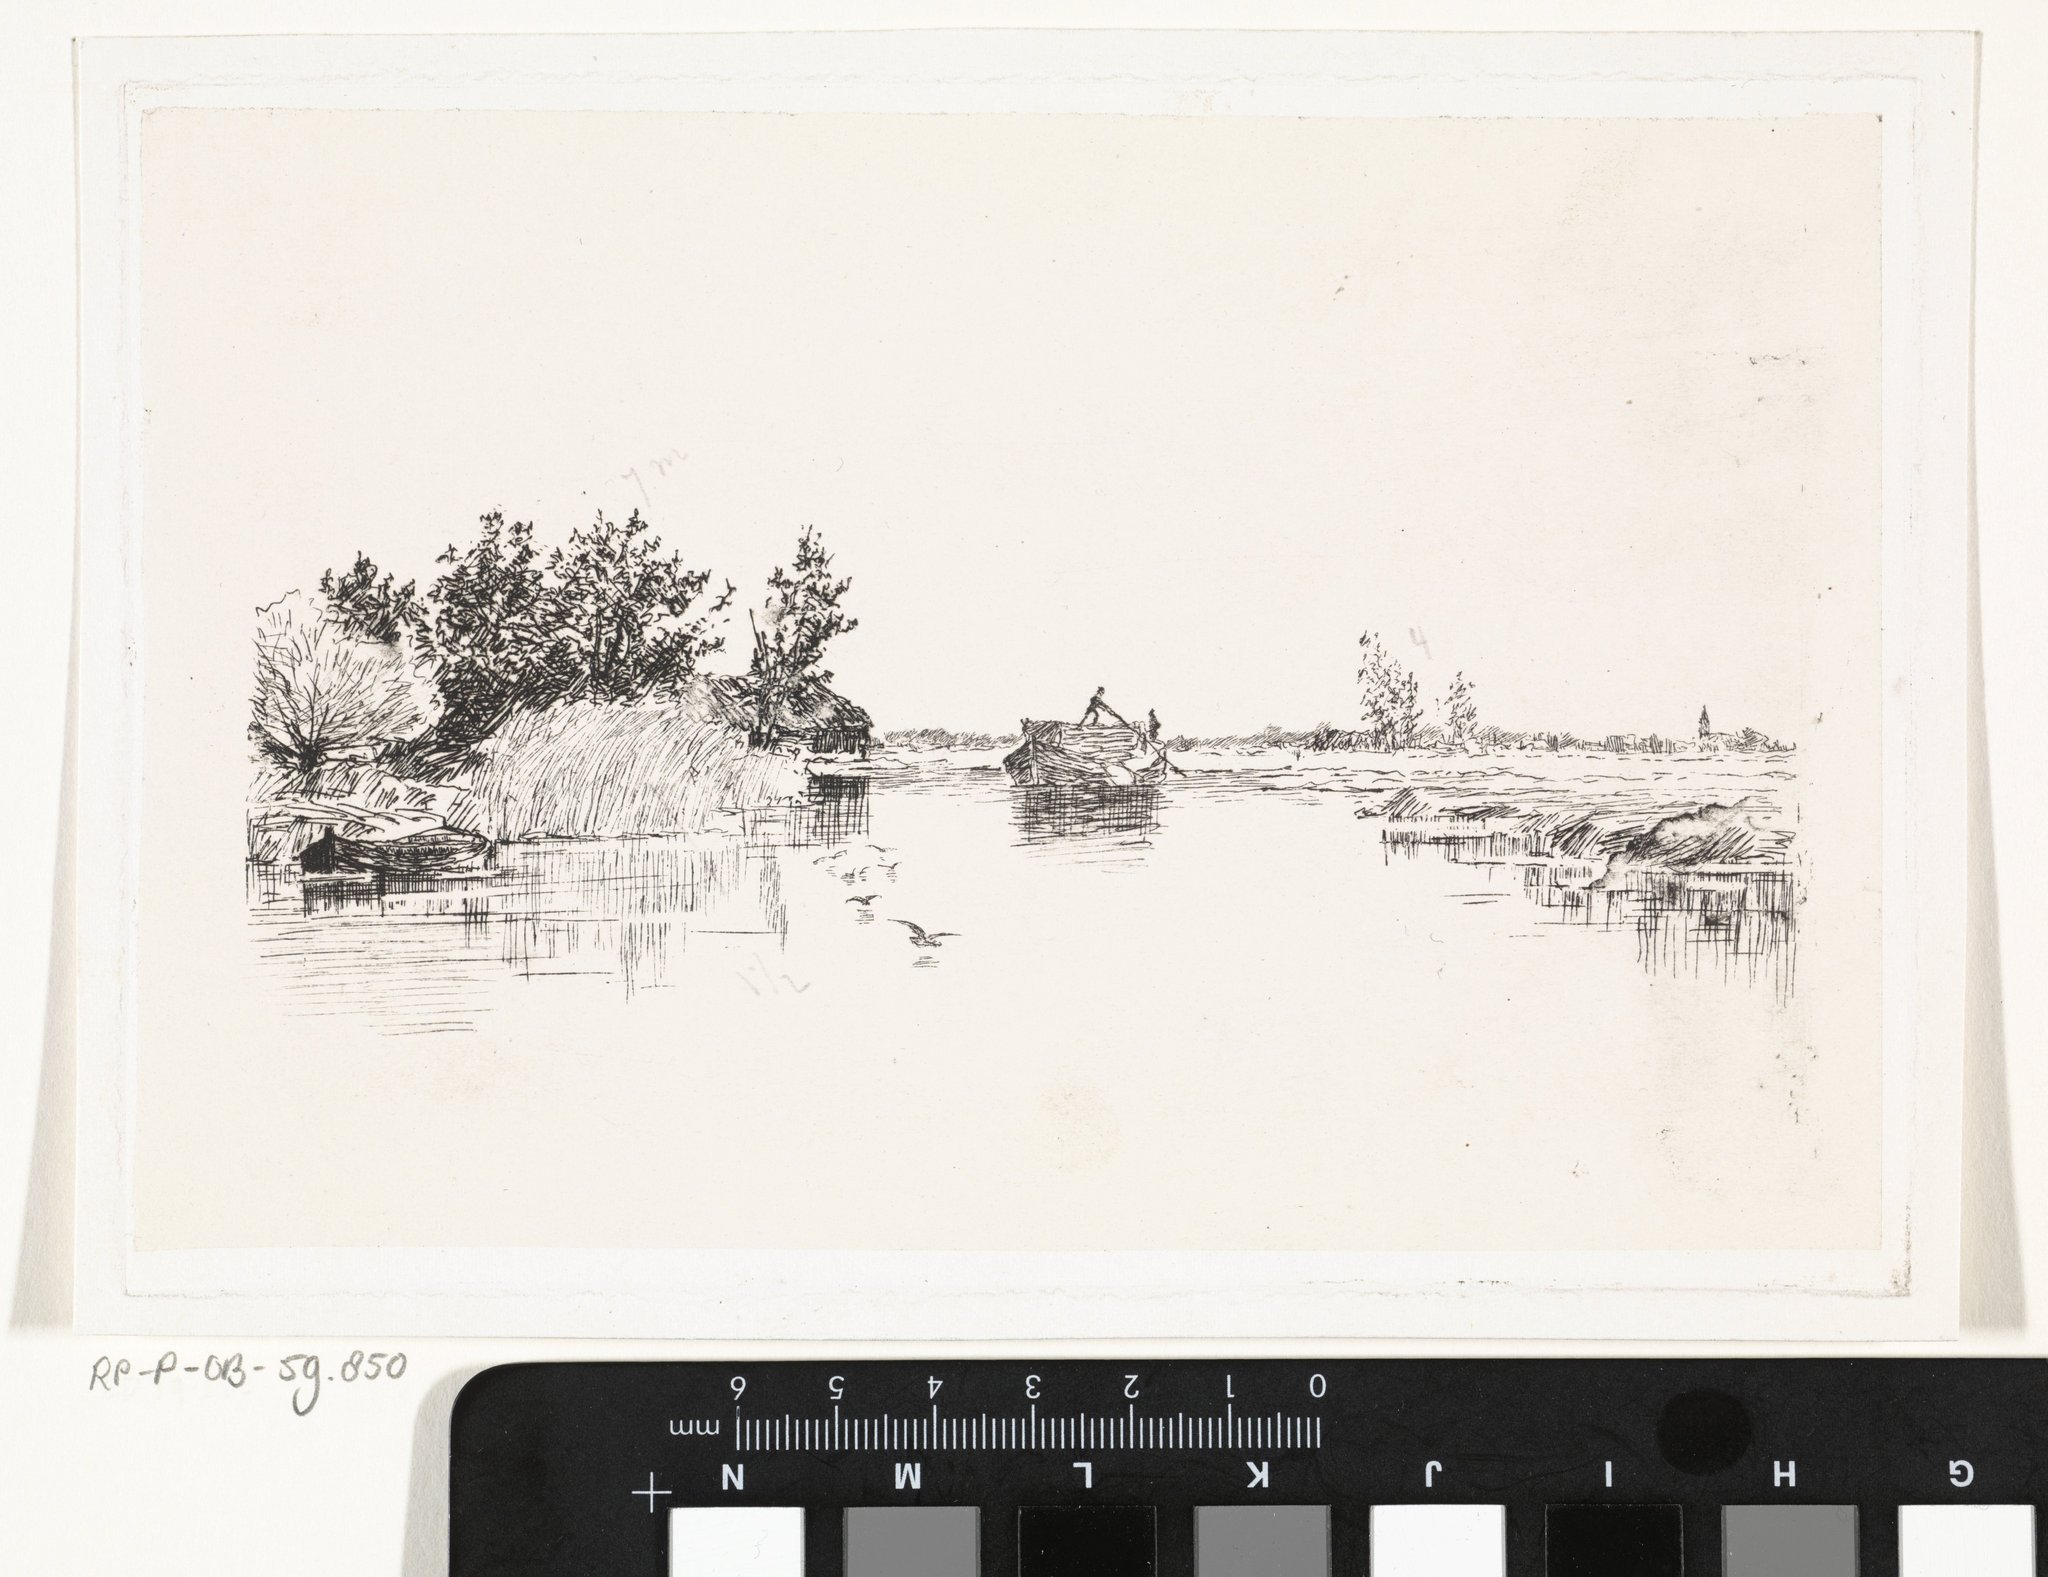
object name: print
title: Rivierlandschap met beladen schuit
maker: elias stark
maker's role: draughtsman, print maker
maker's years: 1849-1933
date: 1859-1933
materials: paper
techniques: etching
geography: netherlands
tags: river, rowing-boat, canoe, etc.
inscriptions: collector's mark: Lugt 2228